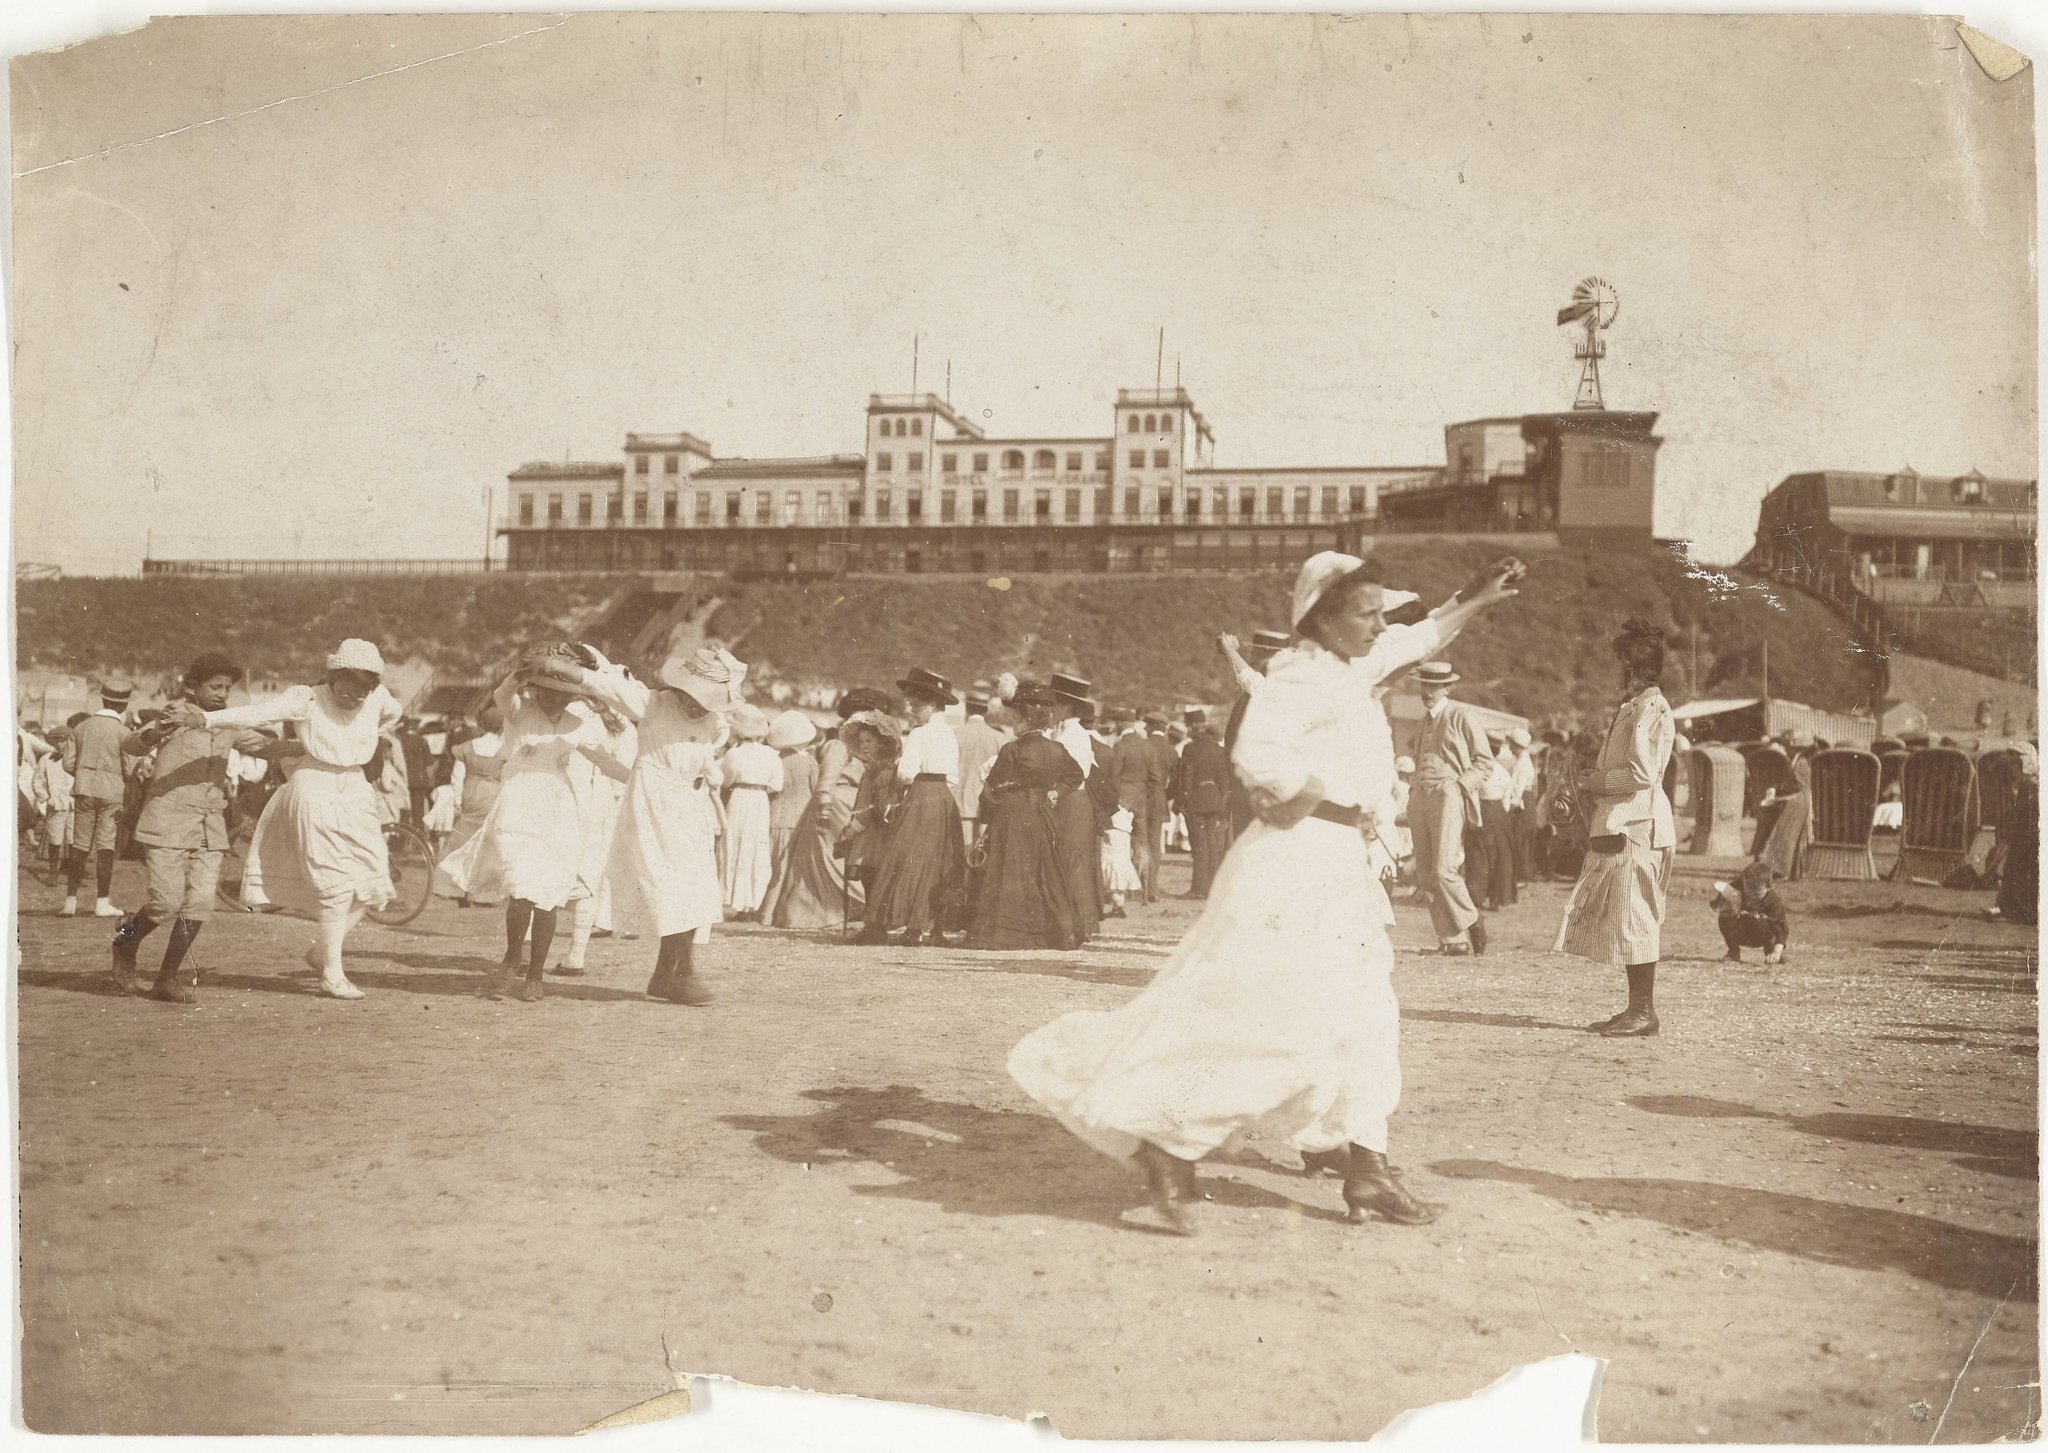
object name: photograph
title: Dansen op het strand in Zandvoort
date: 1900-1905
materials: photographic support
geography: zandvoort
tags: beach (as place of recreation)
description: Vrouwen en kinderen dansen op het strand. Op de achtergrond Hotel d'Orange.